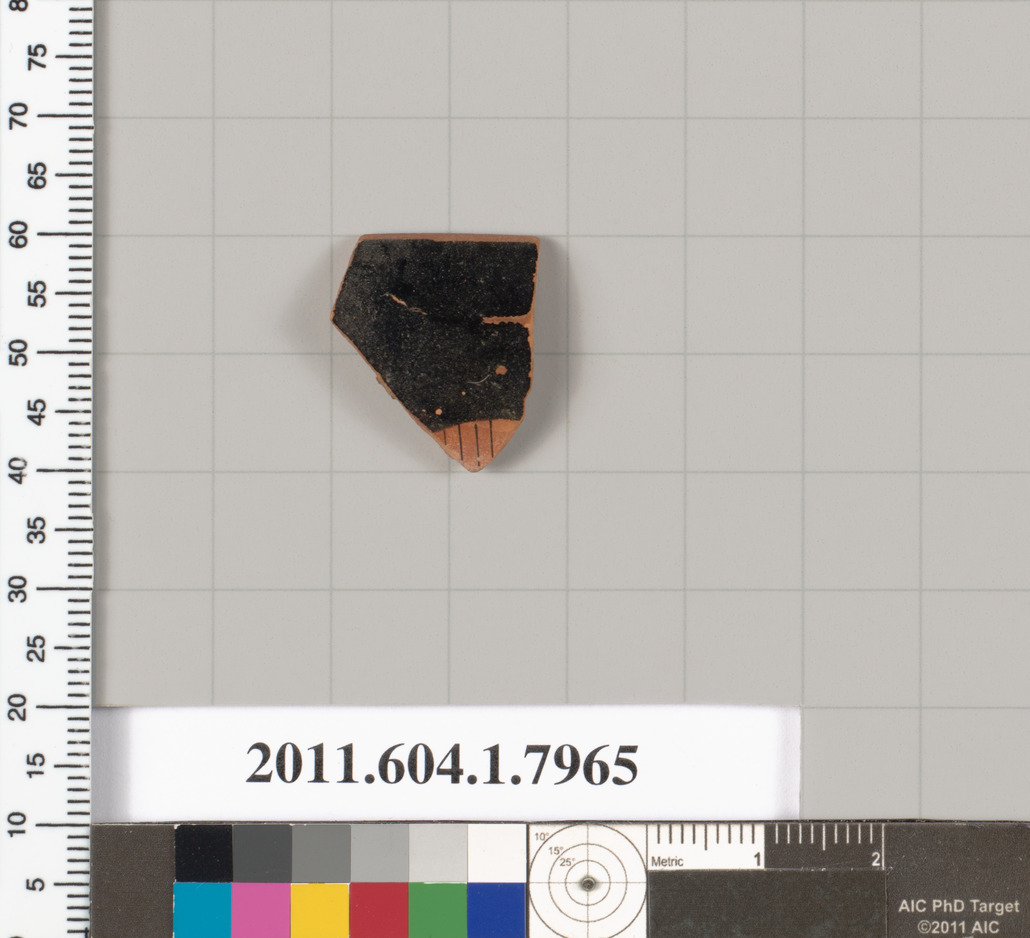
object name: kylix fragment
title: Terracotta rim fragment of a kylix (drinking cup)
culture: greek, attic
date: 460-450 BCE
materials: terracotta